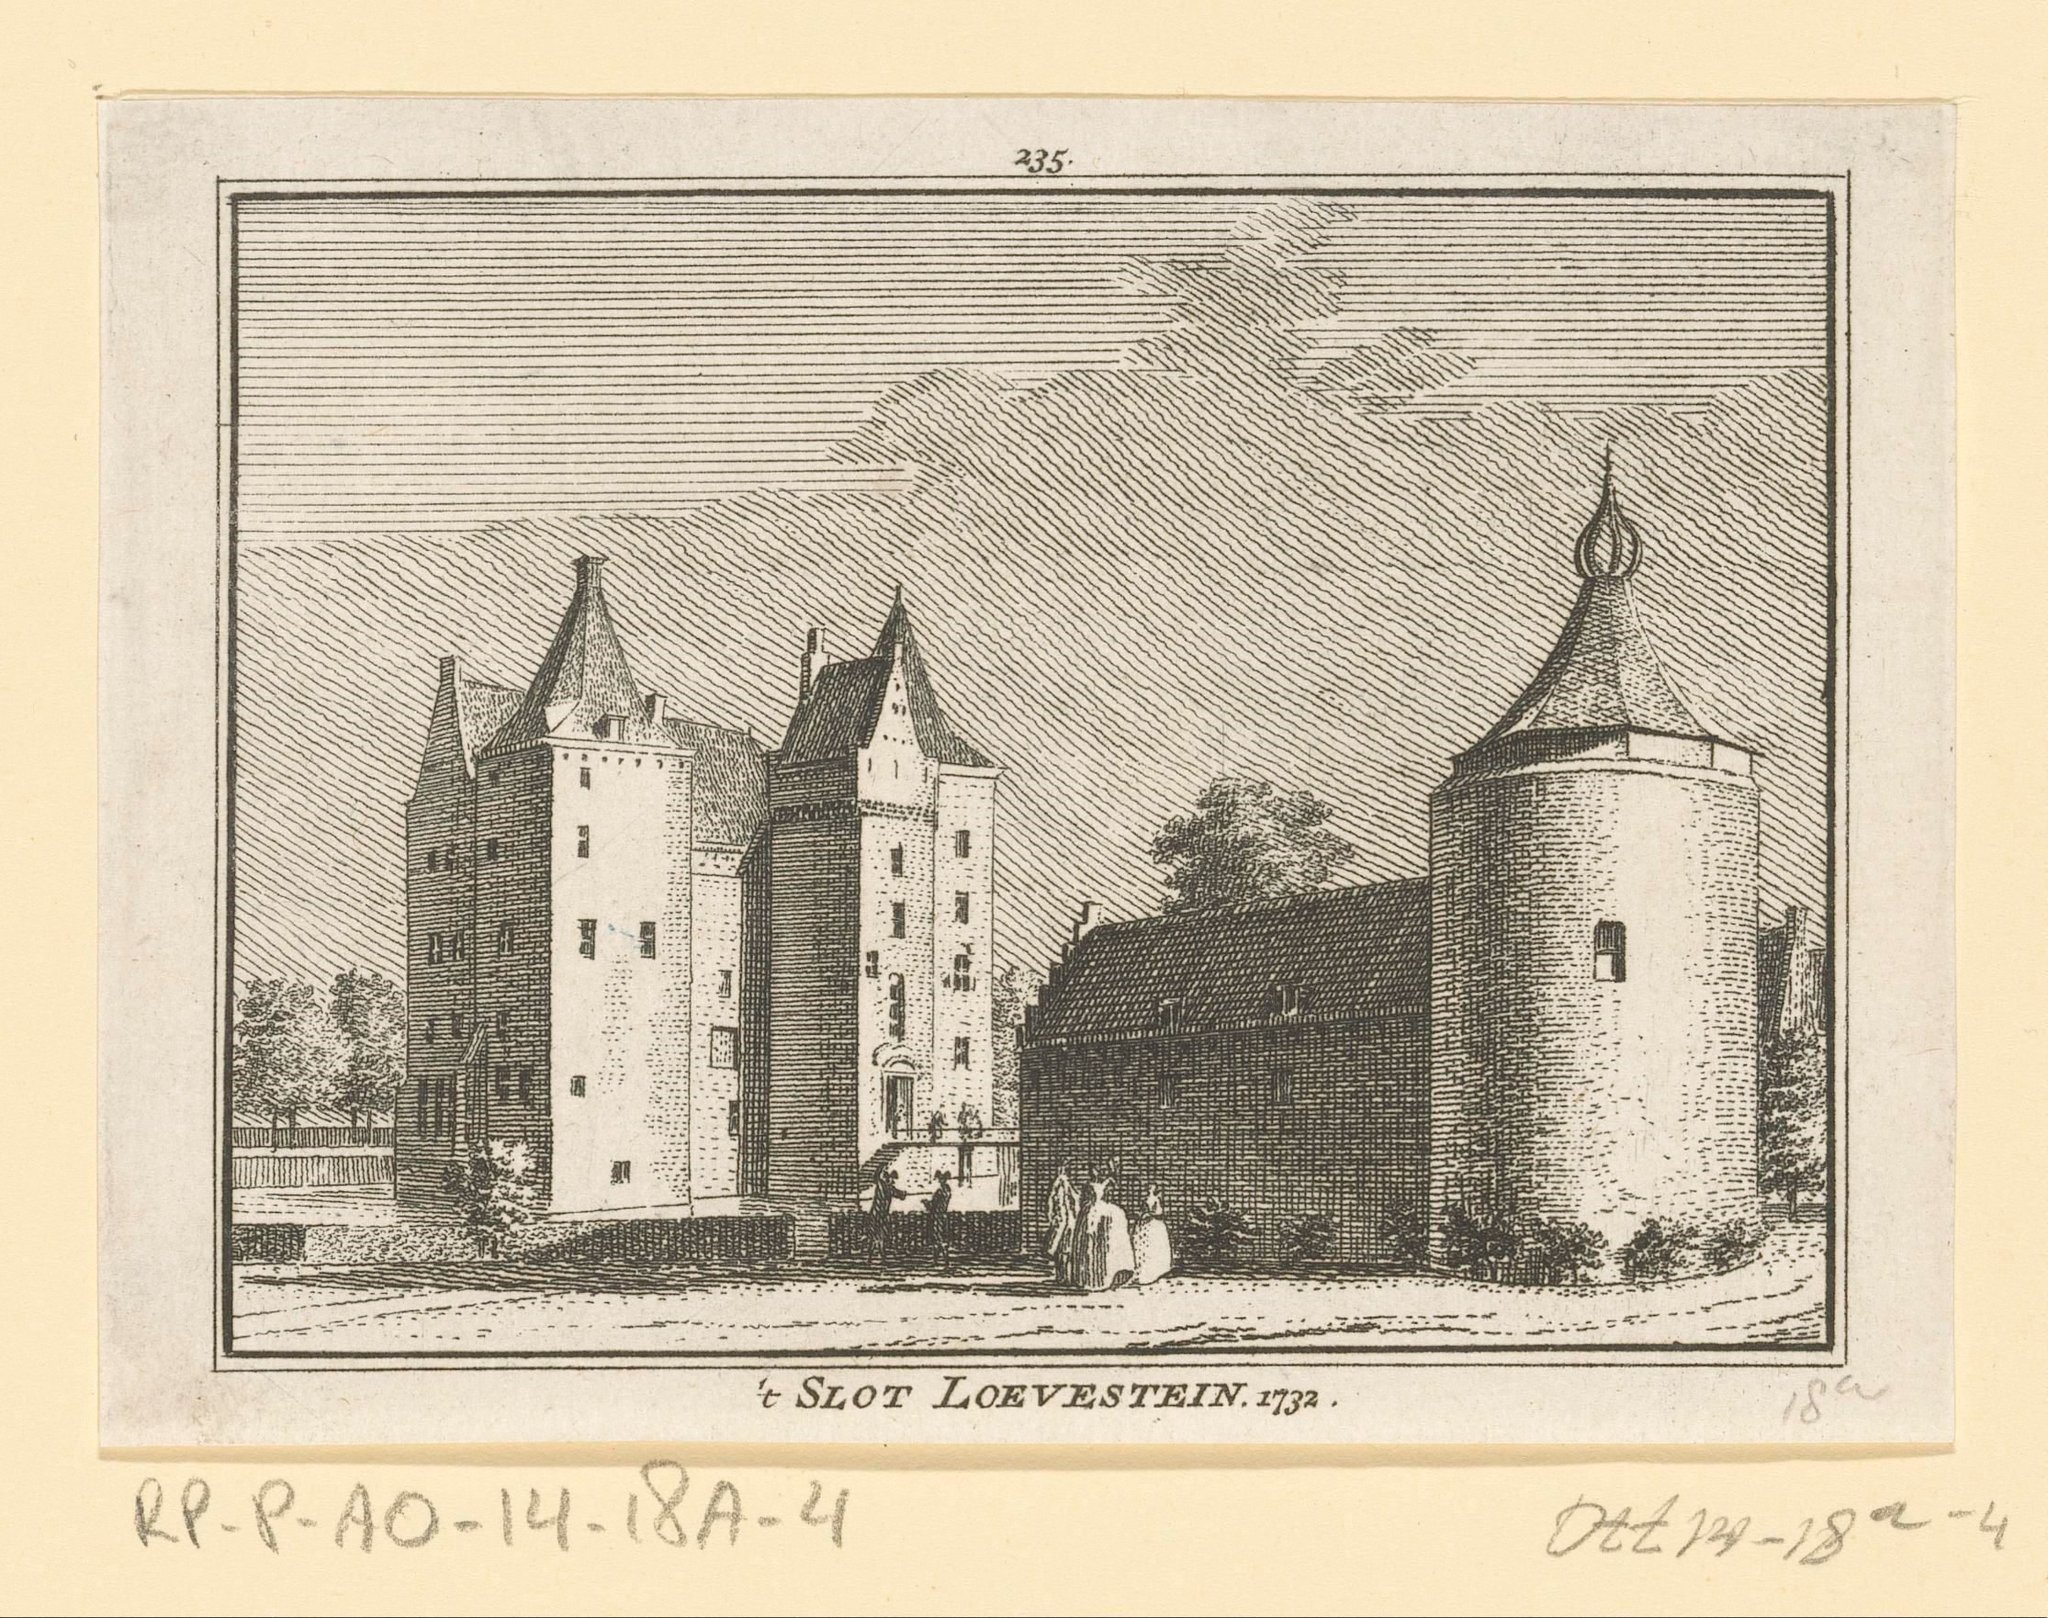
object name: book illustration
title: Gezicht op Slot Loevestein, 1732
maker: hendrik spilman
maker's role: draughtsman, painter, print maker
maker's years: 1721-1784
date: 1750-1792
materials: paper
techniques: etching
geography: haarlem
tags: castle, loevestein castle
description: Prent ook gebruikt in: Het verheerlykt Nederland of kabinet van hedendaagsche gezigten van steden, dorpen (…). 9 delen. Amsterdam: Isaak Tirion en weduwe Isaak Tirion, 1745-1774, dl. 3 (1750), ill. 235. Of in: Nederlandsche tafereelen; of eene keurige verzameling van negen honderd fraaije gezigten van steden, dorpen, sloten, oudheden (….). 9 delen. Amsterdam: Jan de Groot, 1792, dl. 3, ill. 235. Zie RP-T-1900-A-4352 voor de tekening waar deze prent op is gebaseerd.